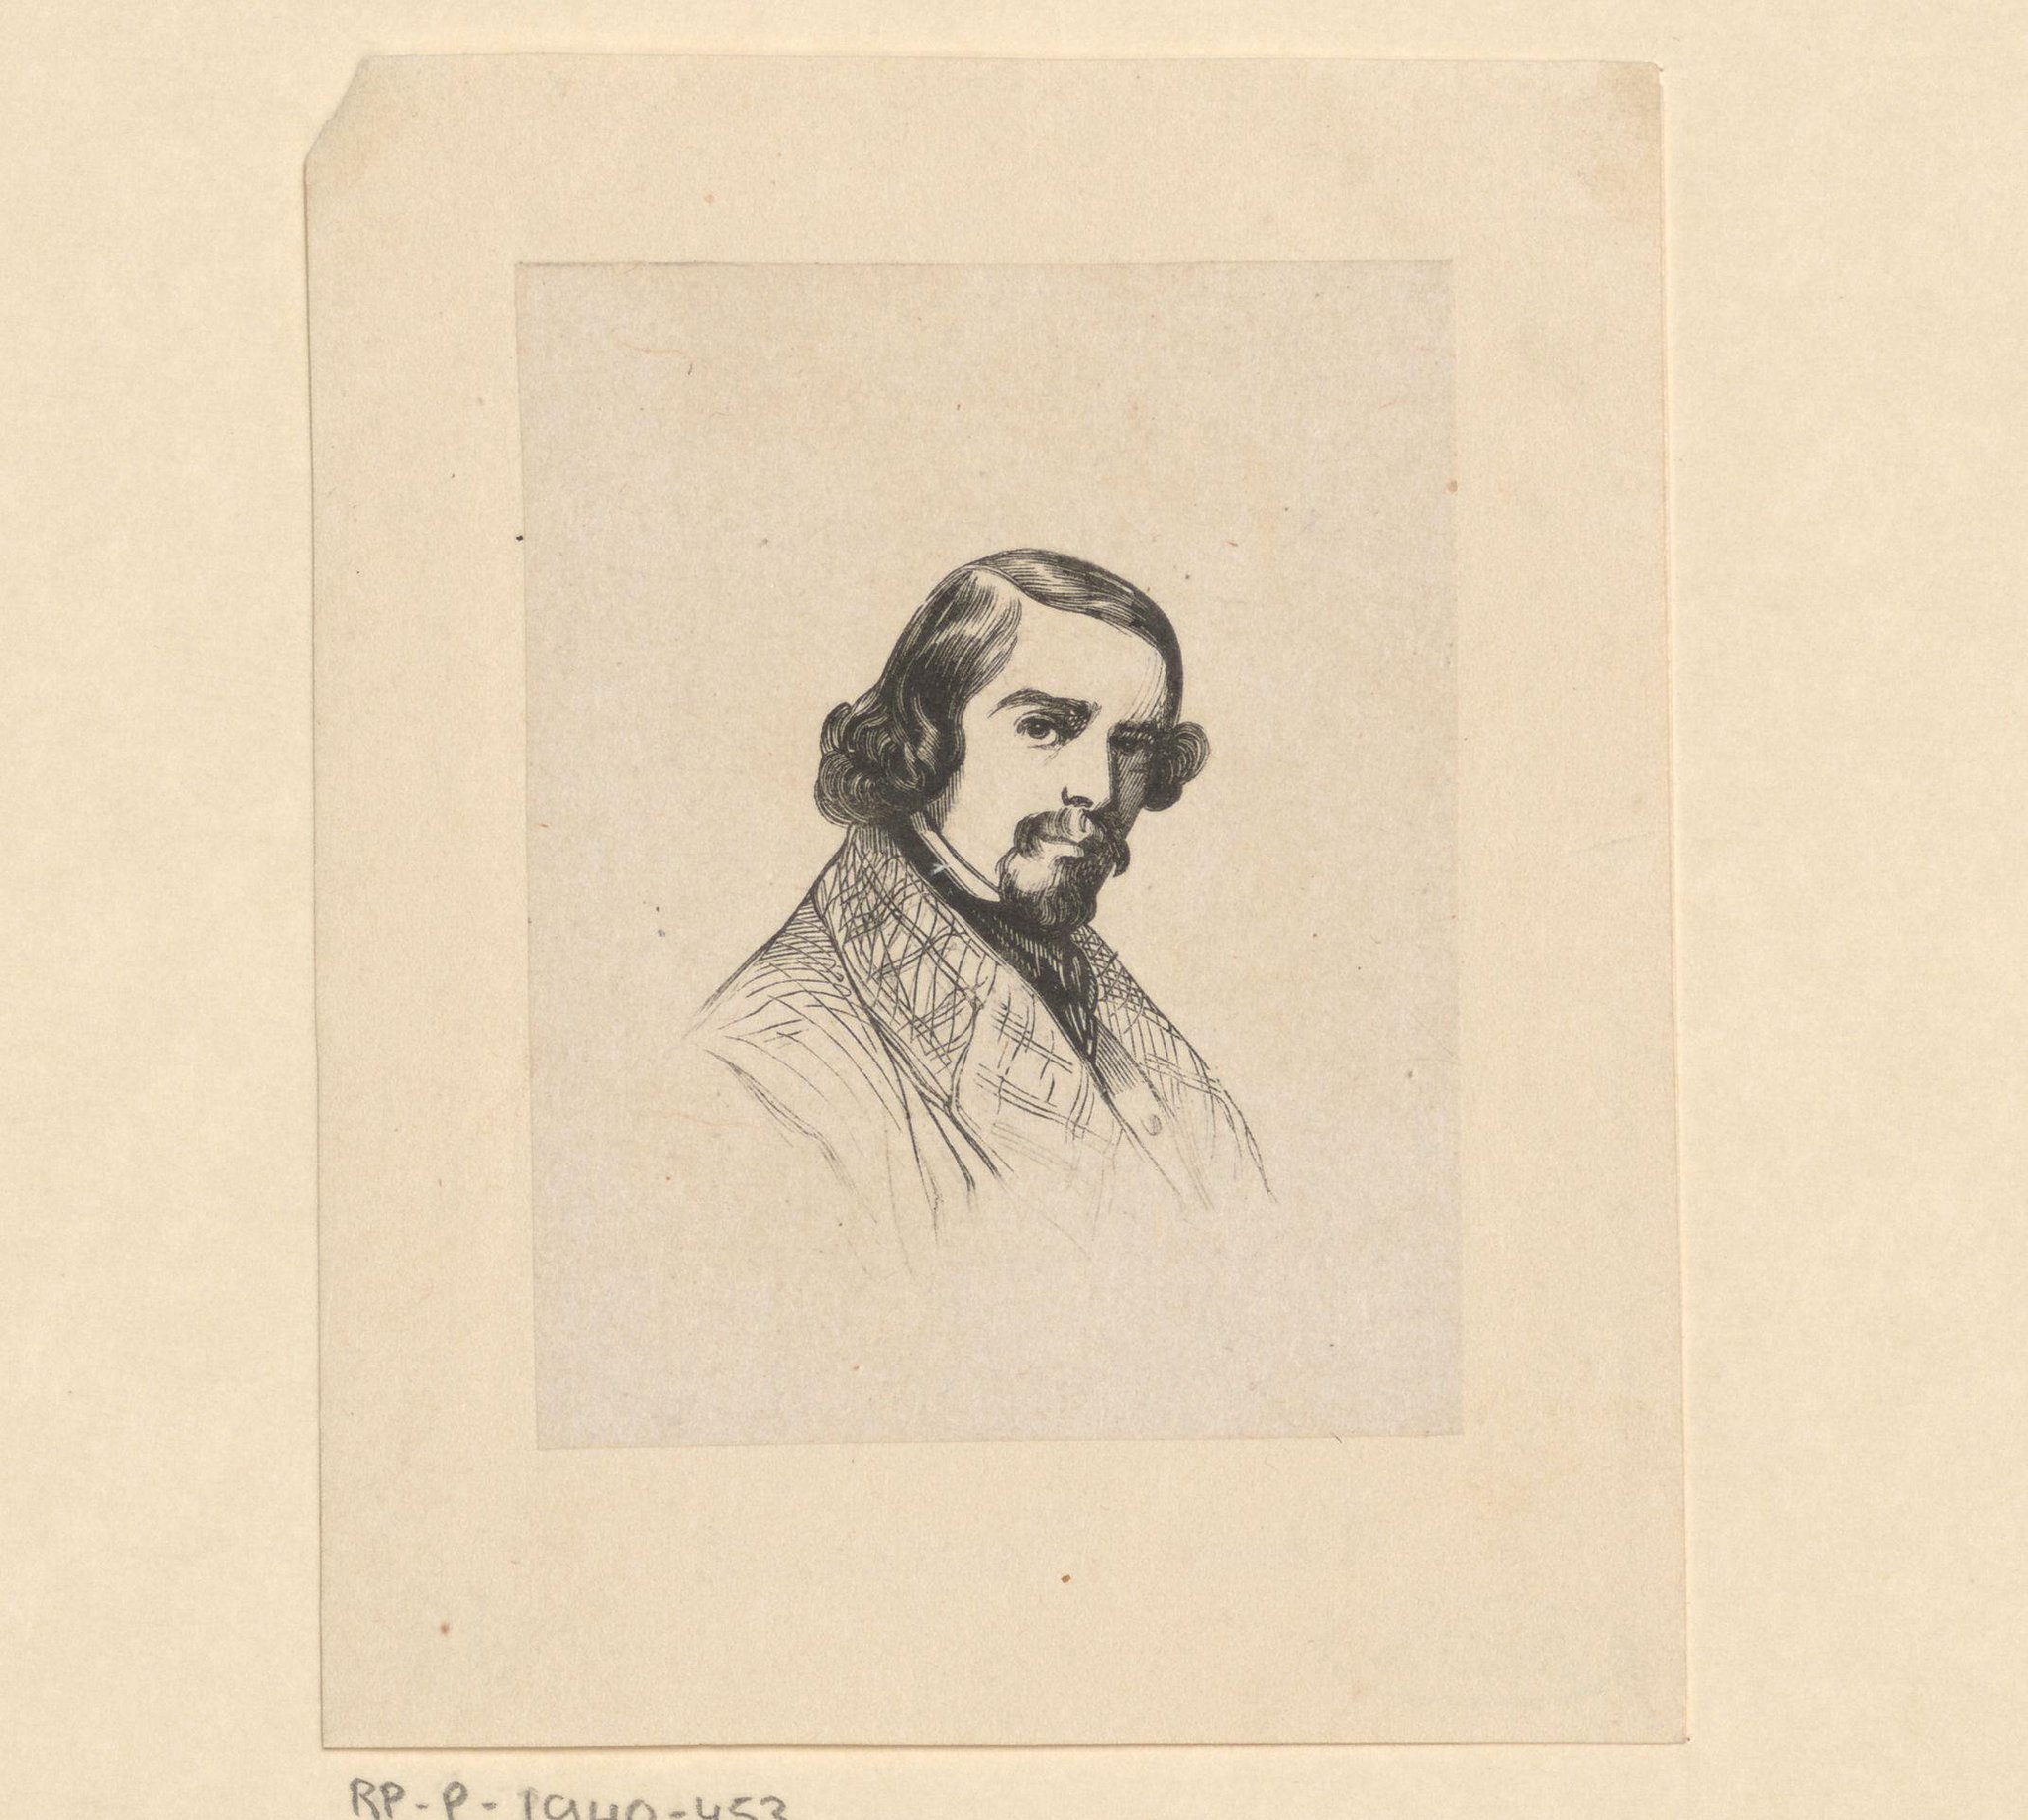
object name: print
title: Portret van Charles Baugniet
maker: Anonymous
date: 1842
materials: paper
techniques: engraving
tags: brussels, print maker, charles baugniet, historical persons, portrait, self-portrait of artist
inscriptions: collector's mark: Lugt 2228, collector's mark: Lugt 2760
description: Prent met tekst op verso verschenen in: Immerzeel, Johannes. De levens en werken der Hollandsche en Vlaamsche kunstschilders (...). Amsterdam: Johannes Christoffel van Kesteren, 1842, dl. 1, p. 33.